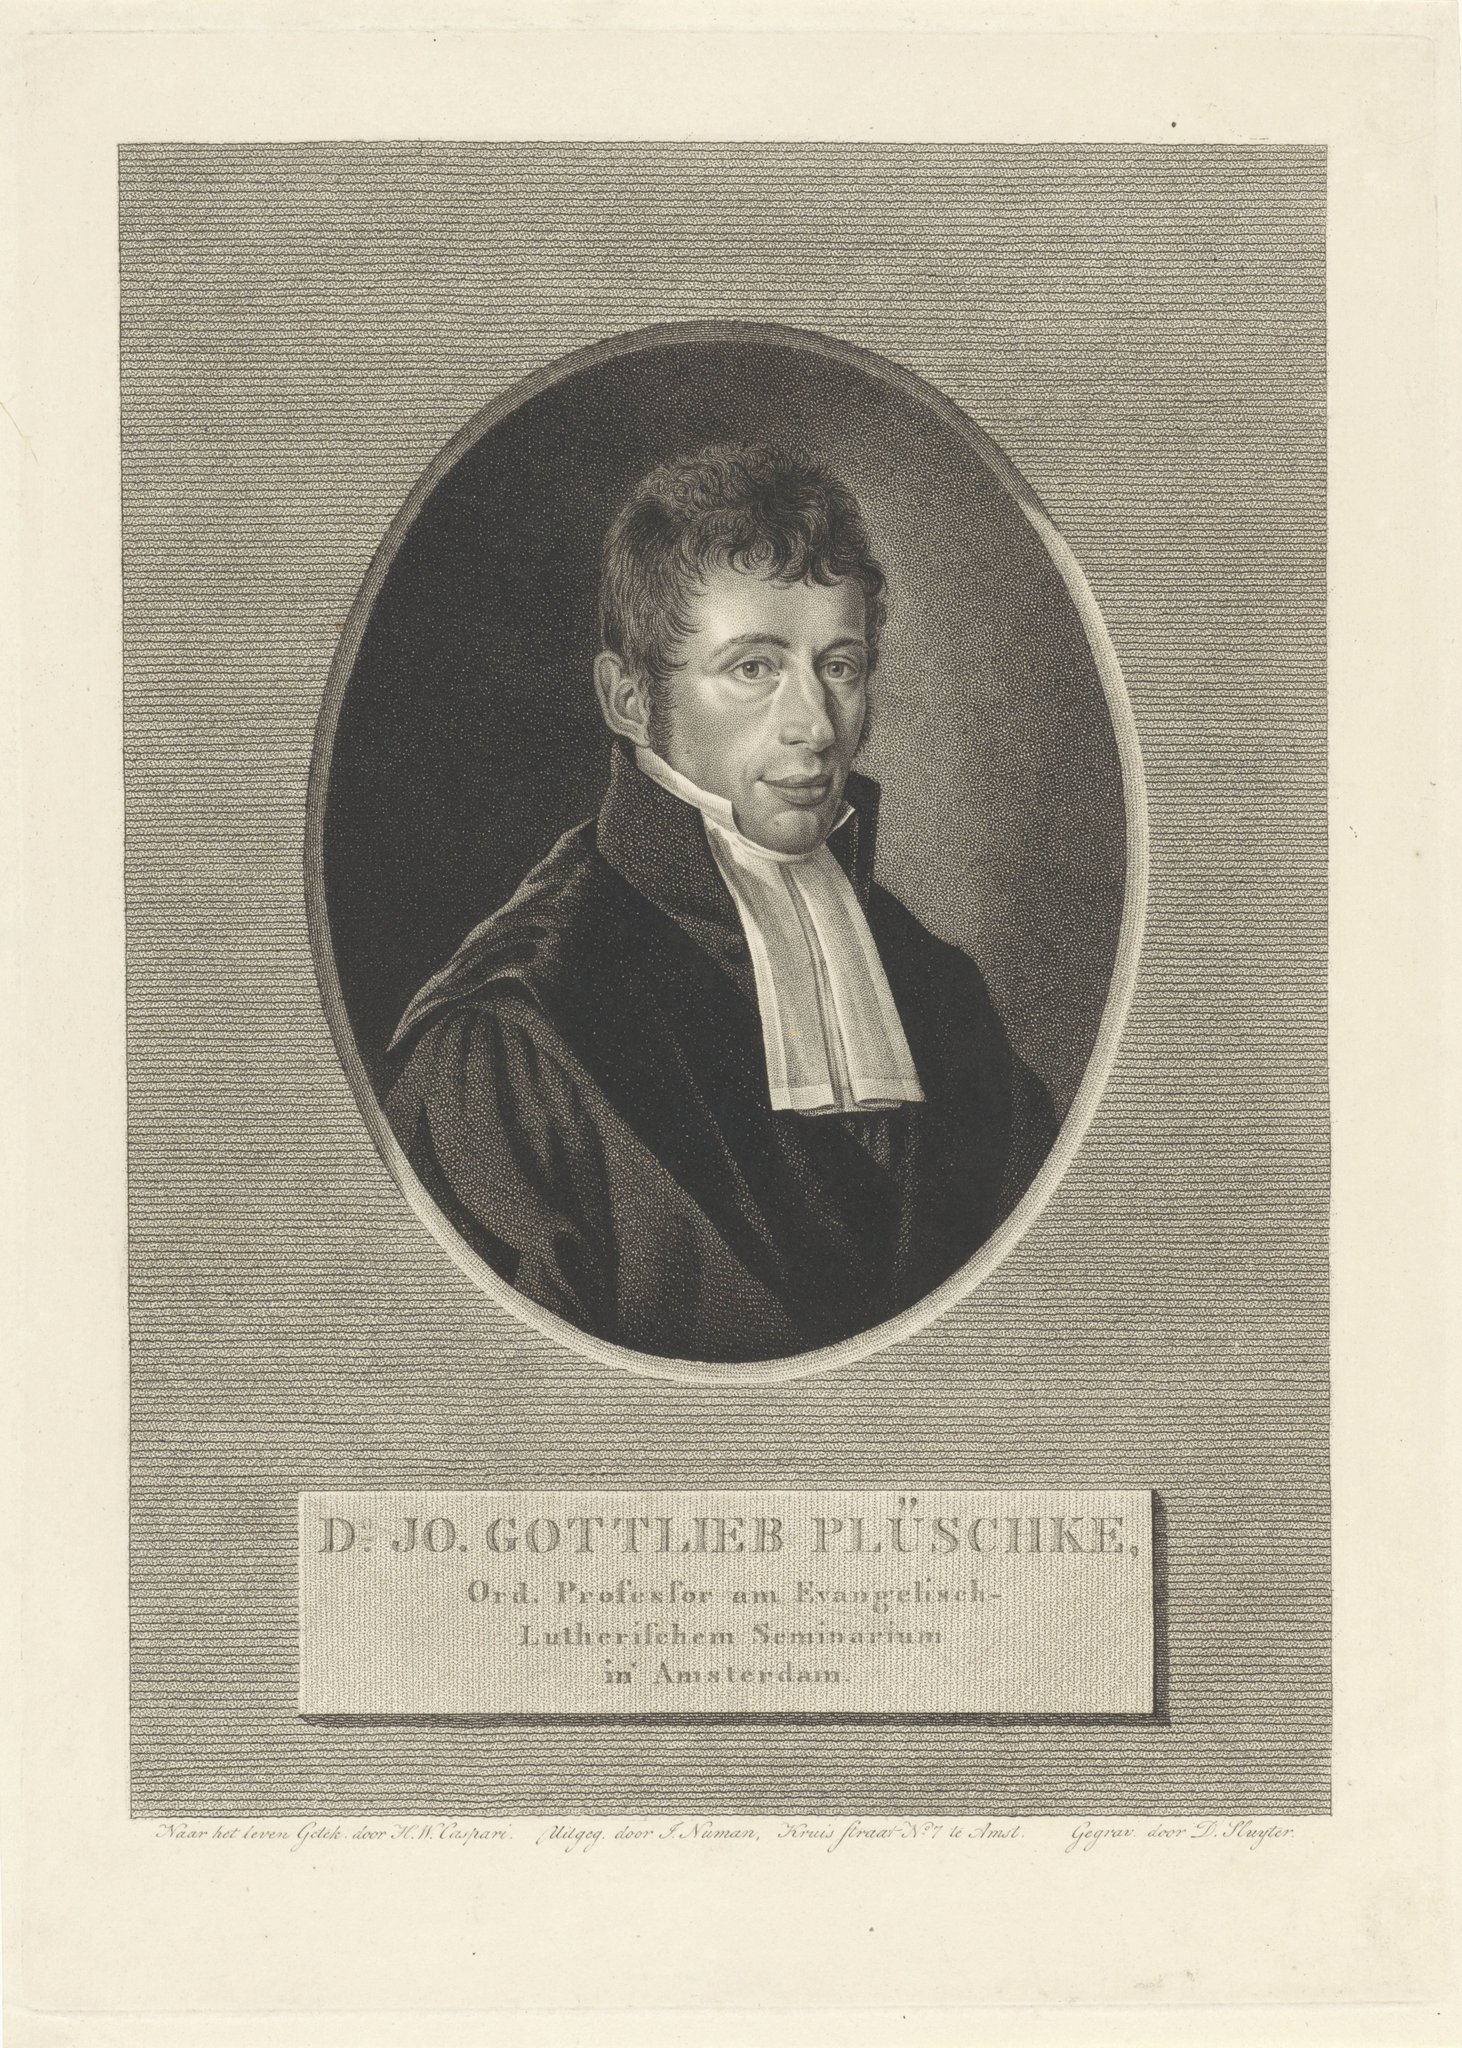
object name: print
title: Portret van Johann Gottlieb Plüschke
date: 1812-1825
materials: paper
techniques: engraving, etching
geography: amsterdam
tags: roztoka, theoloog, hoogleraar, johann gottlieb plüschke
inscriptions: collector's mark: Lugt 2228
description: Portret van Johann Gottlieb Plüschke, professor aan het Evangelisch-Lutherse Seminarie in Amsterdam.